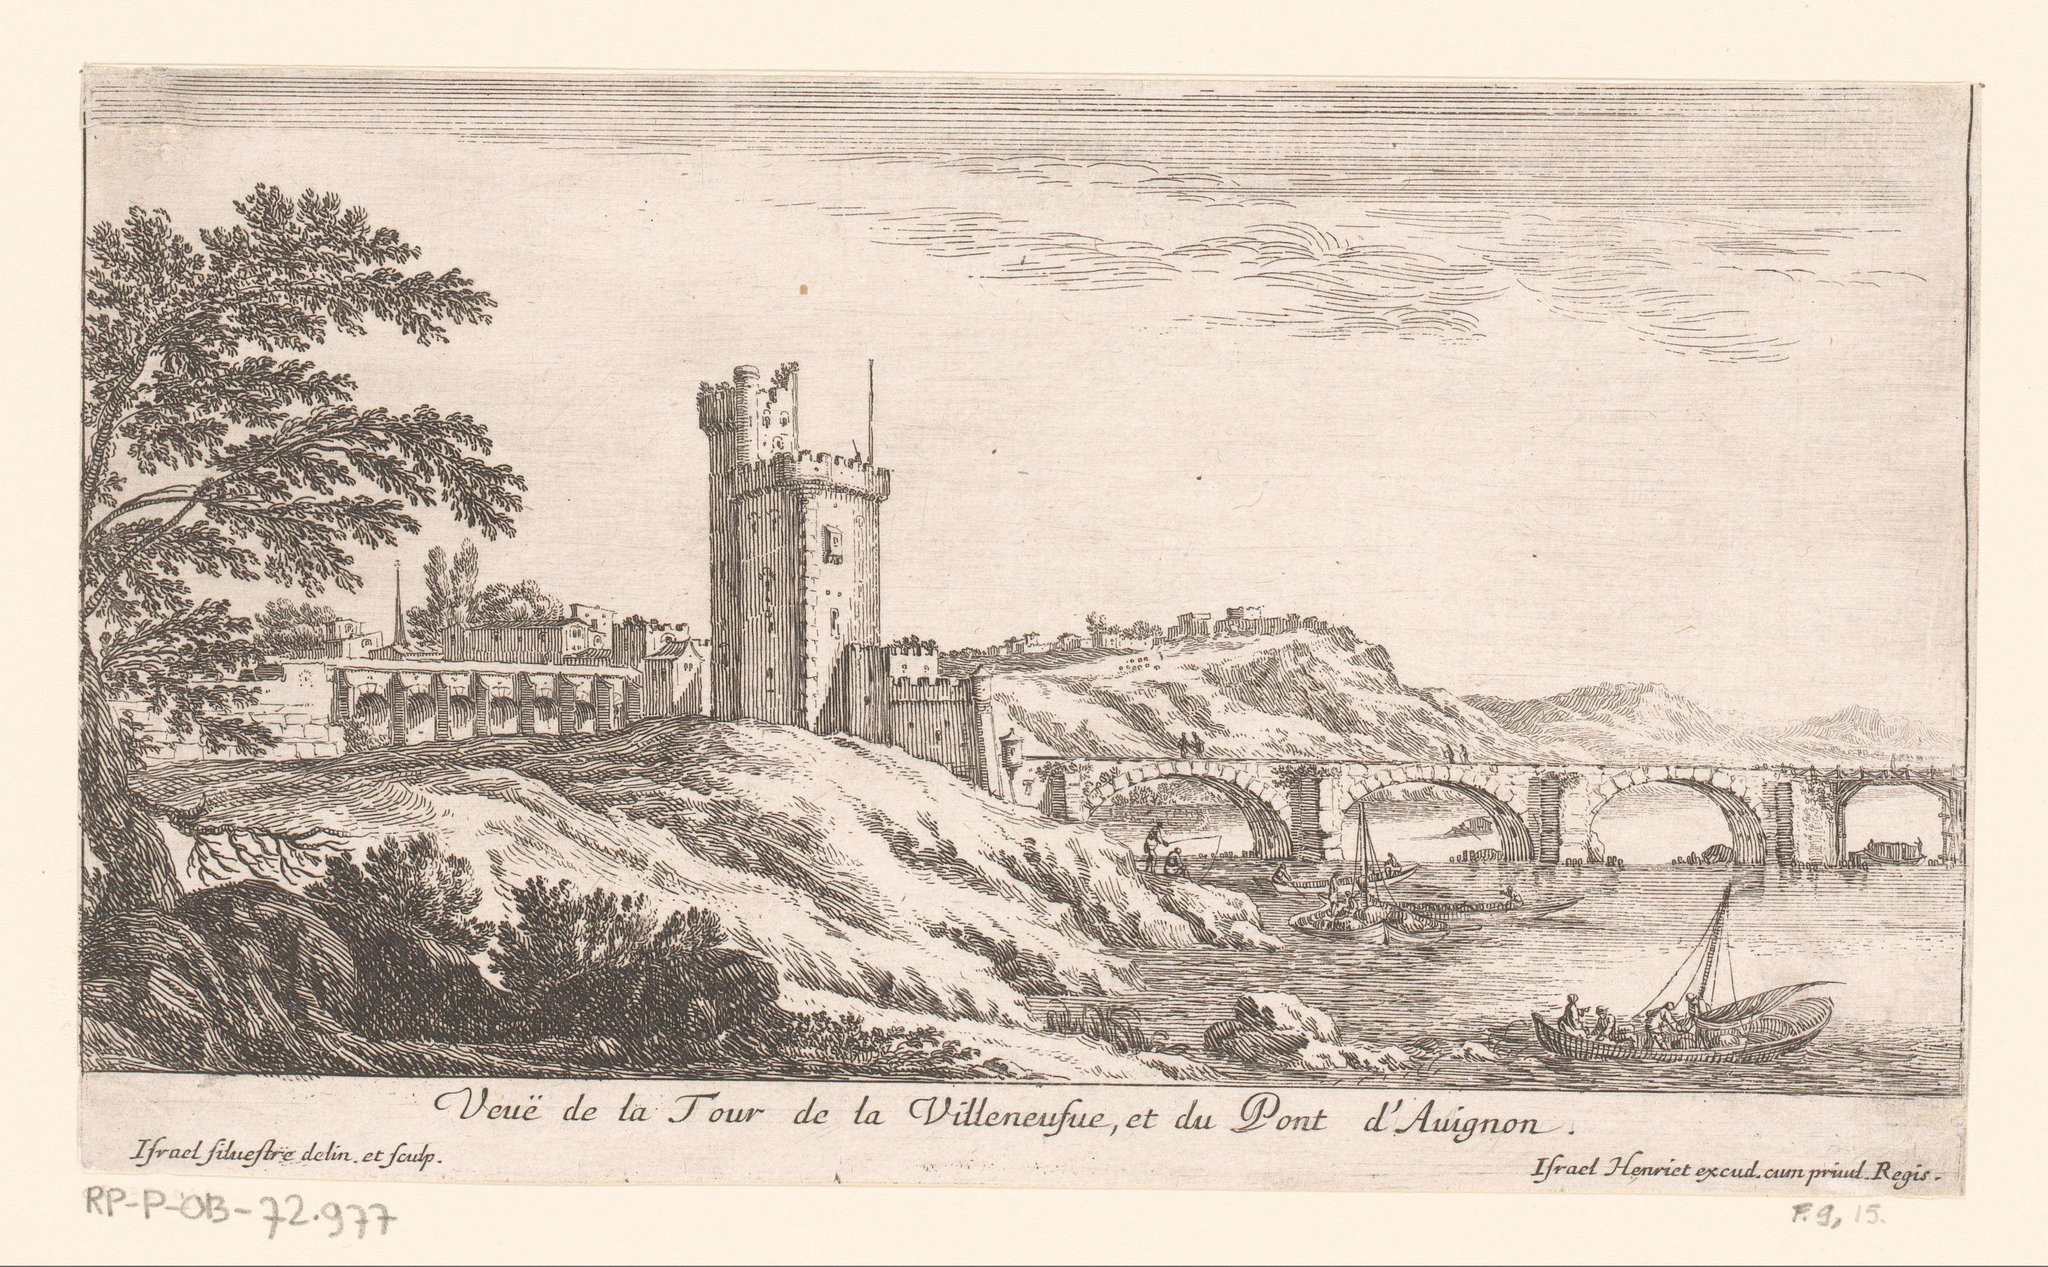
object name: print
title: Gezicht op de Pont Saint-Bénézet en de toren van het fort van Villeneuve-lès-Avignon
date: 1654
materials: paper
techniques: etching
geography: france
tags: landscape with bridge, viaduct or aqueduct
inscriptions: collector's mark: Lugt 240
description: Prent maakt deel uit van een serie van zestien prenten, deels ongenummerd.